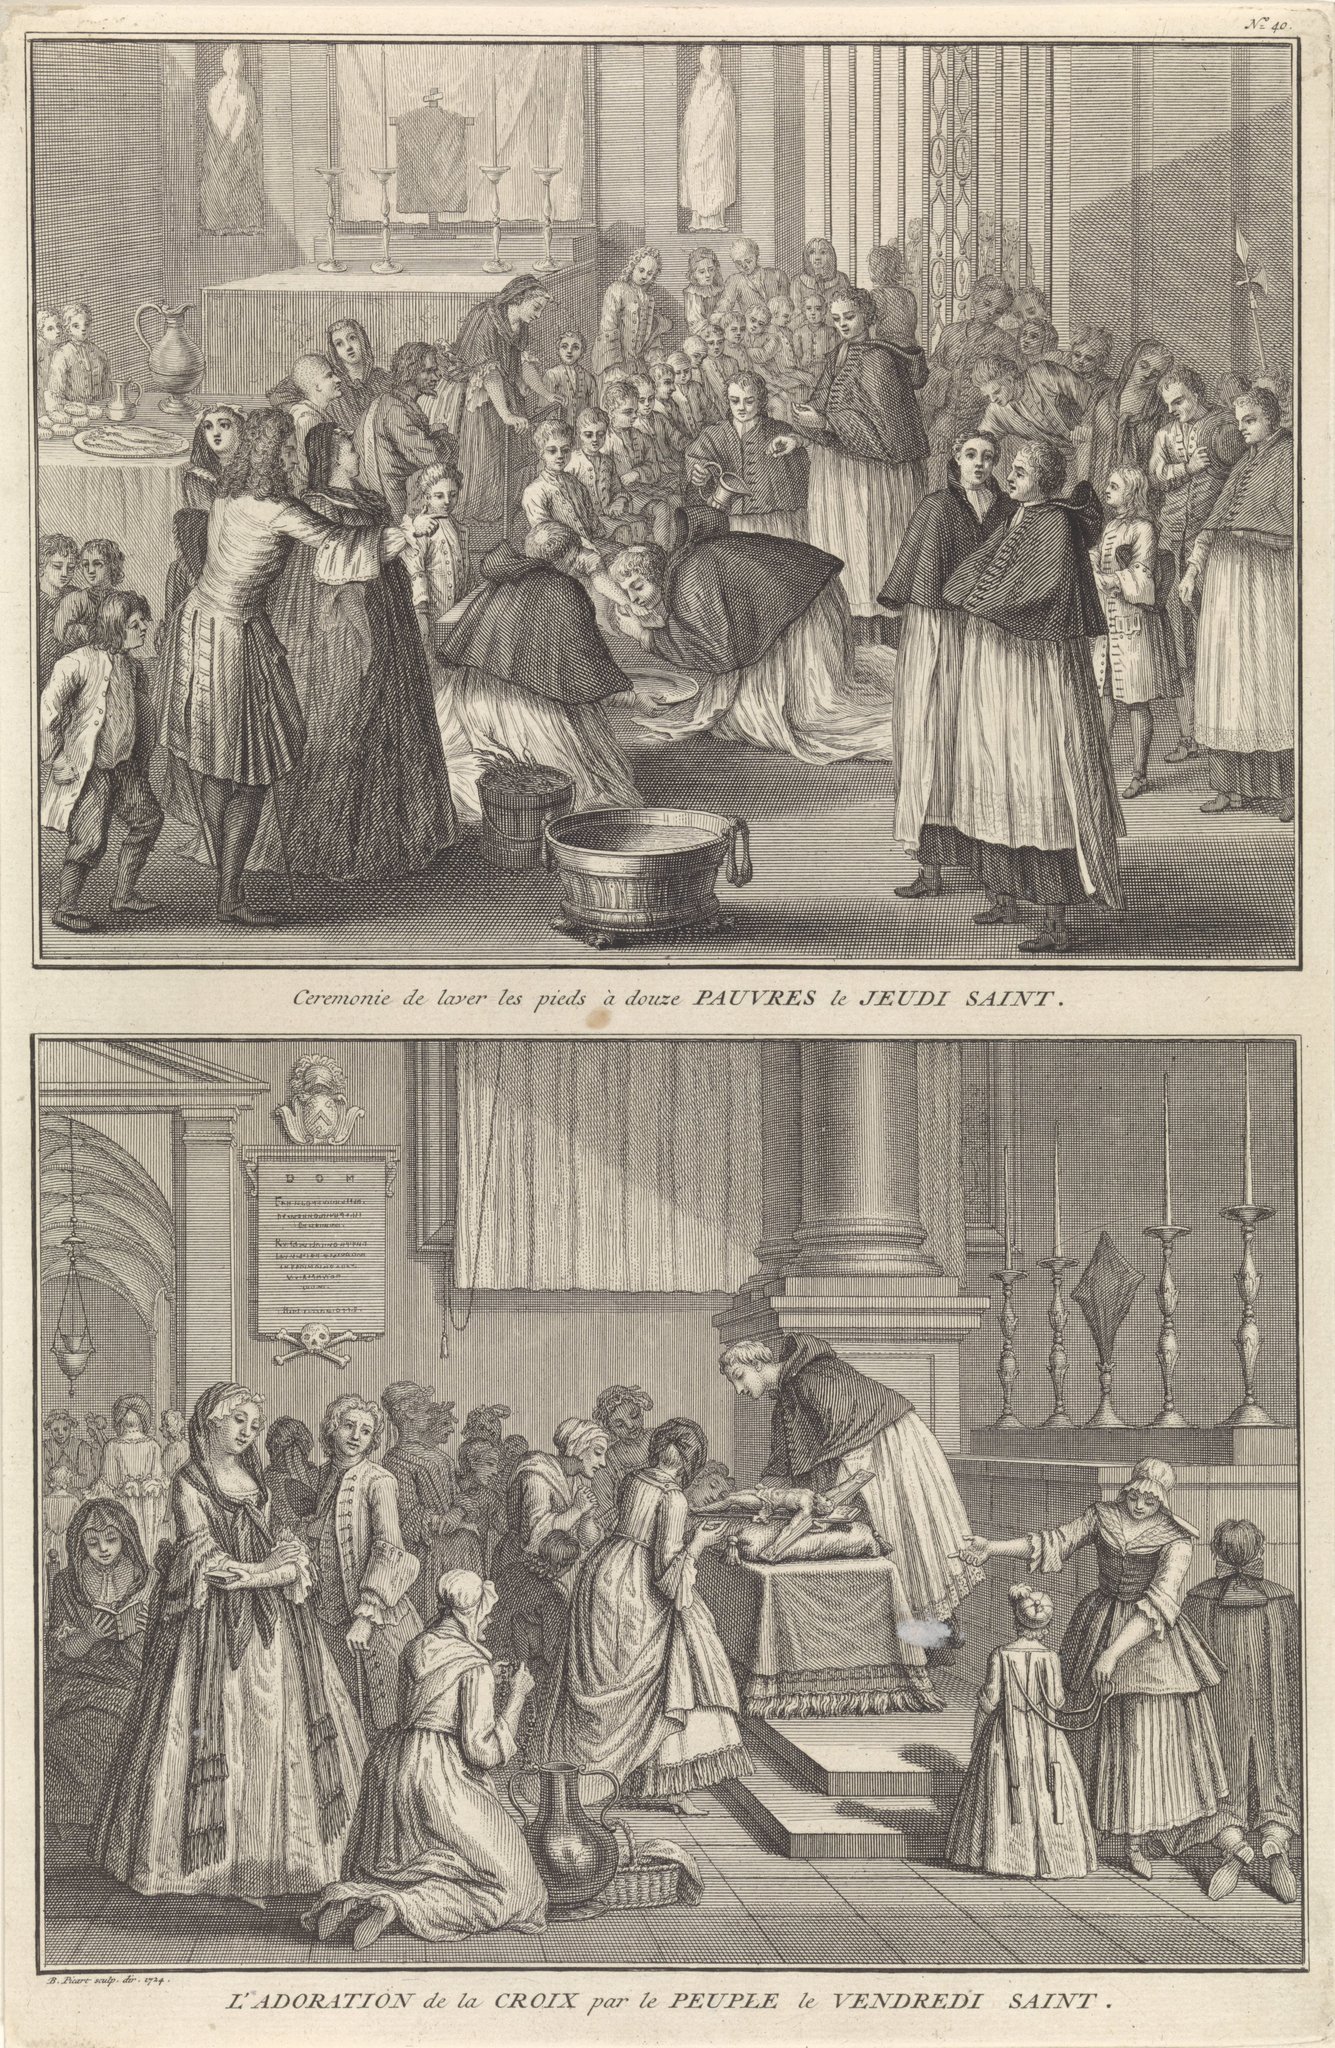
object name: print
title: Voetwassing op Witte Donderdag en de aanbidding van het kruis op Goede Vrijdag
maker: bernard picart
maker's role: draughtsman, print maker, publisher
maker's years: 1673-1733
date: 1724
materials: paper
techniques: engraving, etching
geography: amsterdam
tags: maundy thursday, good friday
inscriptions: collector's mark: Lugt 2233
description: Prent gebruikt in en mogelijk gebruikt in andere edities van: Picart, Bernard. Ceremonies et coutumes religieuses de tous les peuples du monde (...). Tome second. Qui contient la suite des ceremonies religieuses en usage chez les catholiques. Deel 2. Amsterdam: Jean Frederic Bernard, 1723, na p. 20.